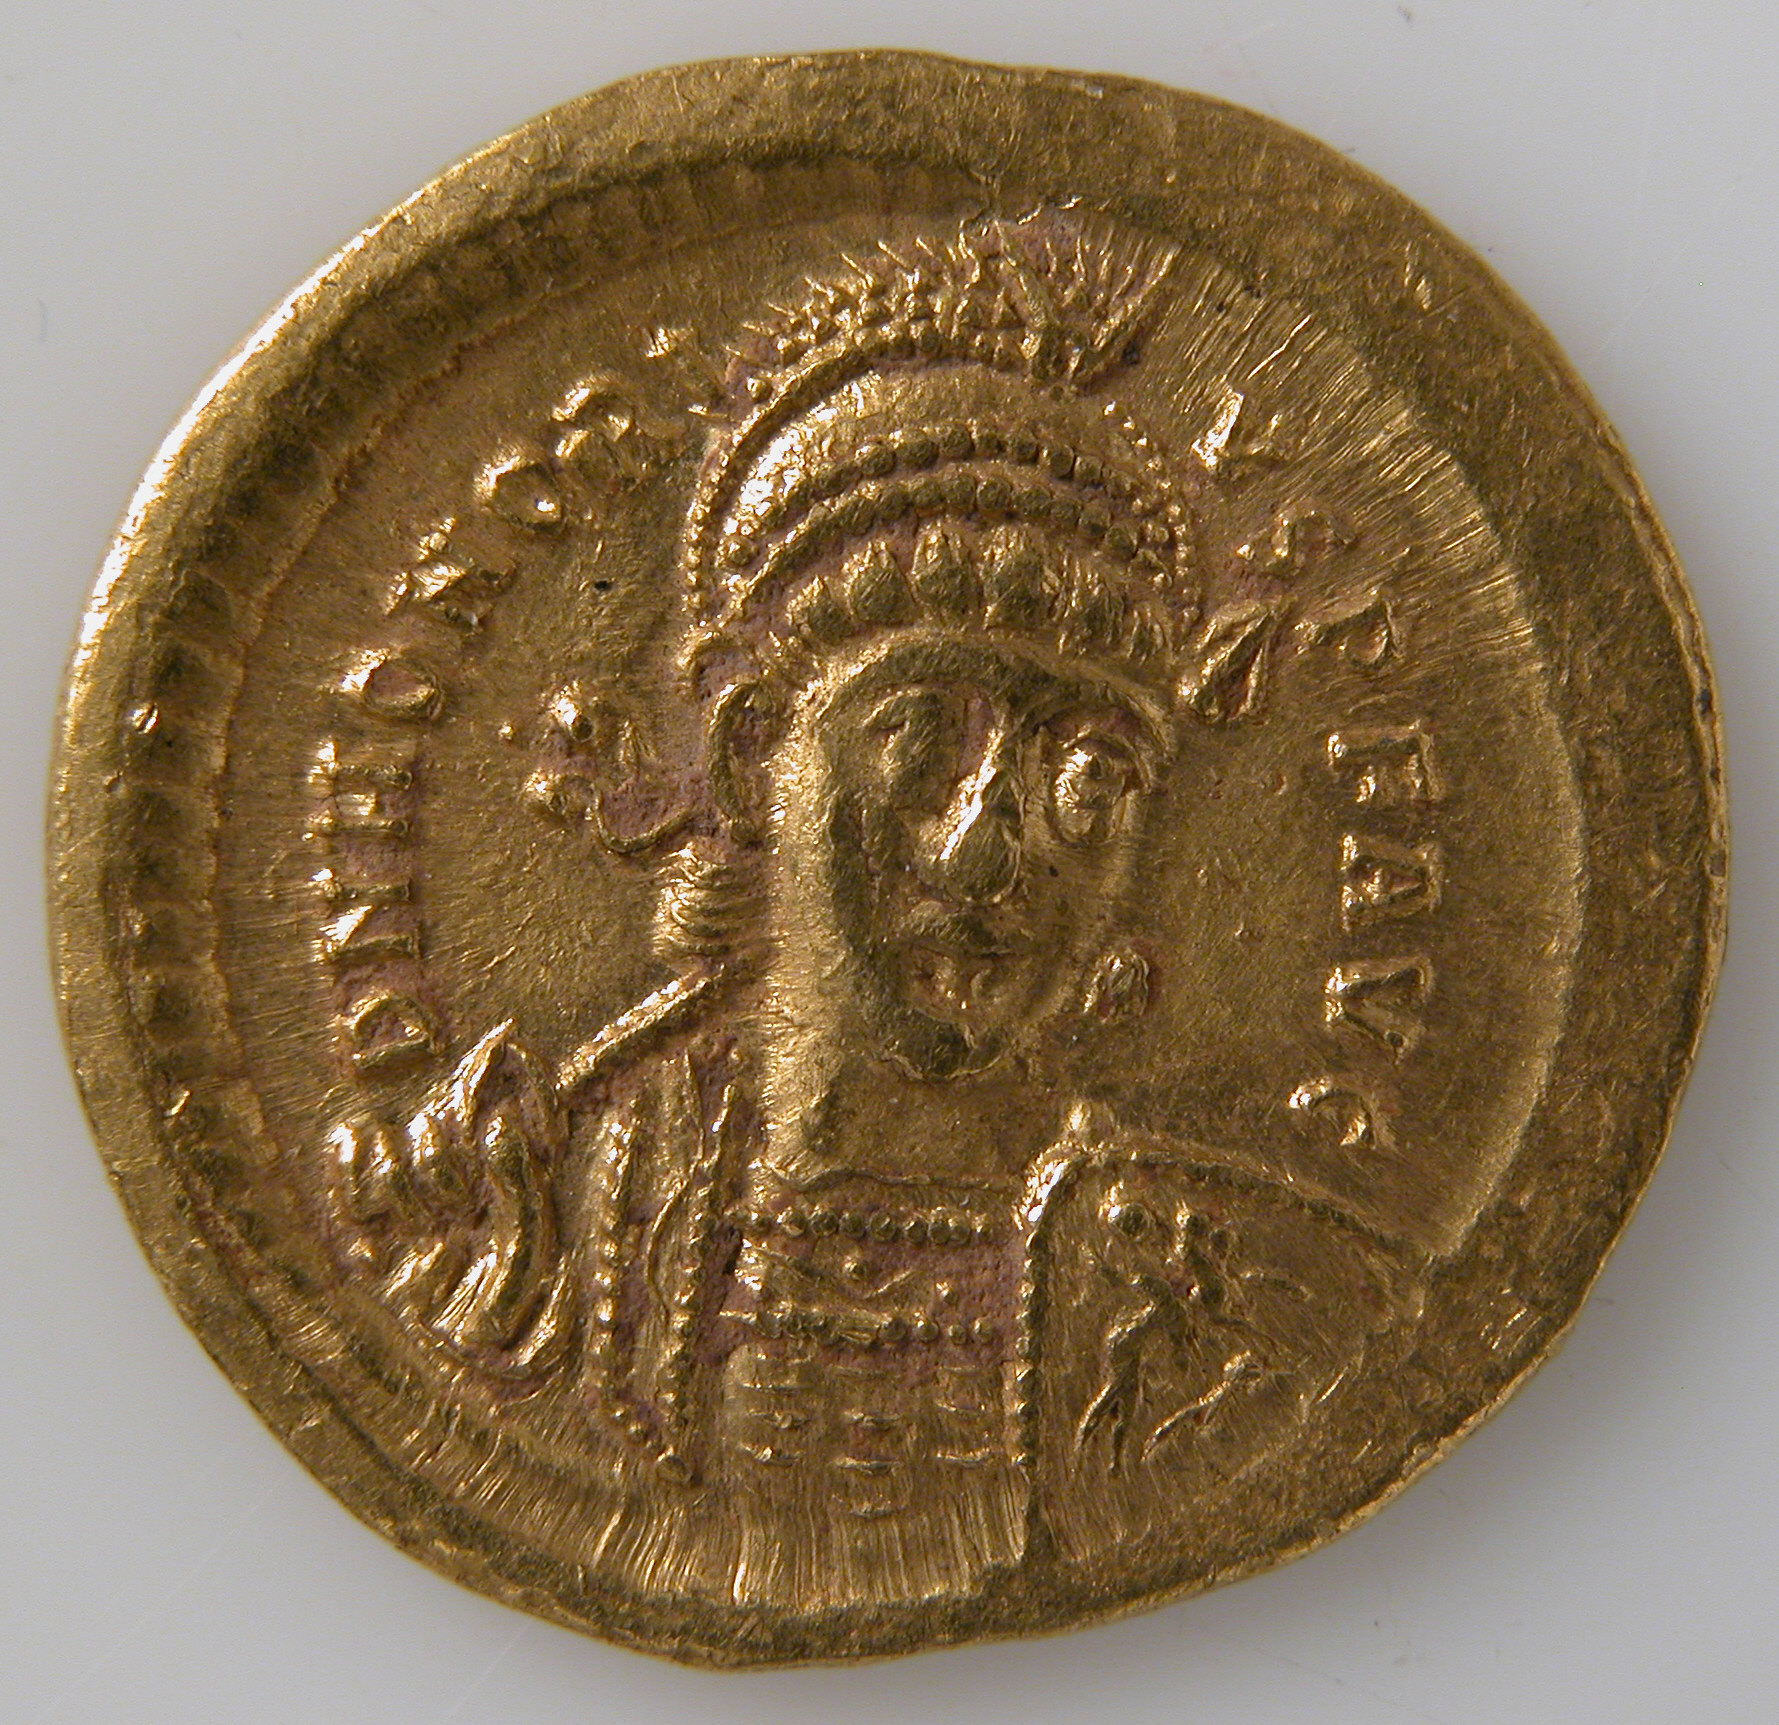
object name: solidus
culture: byzantine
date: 395-423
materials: gold